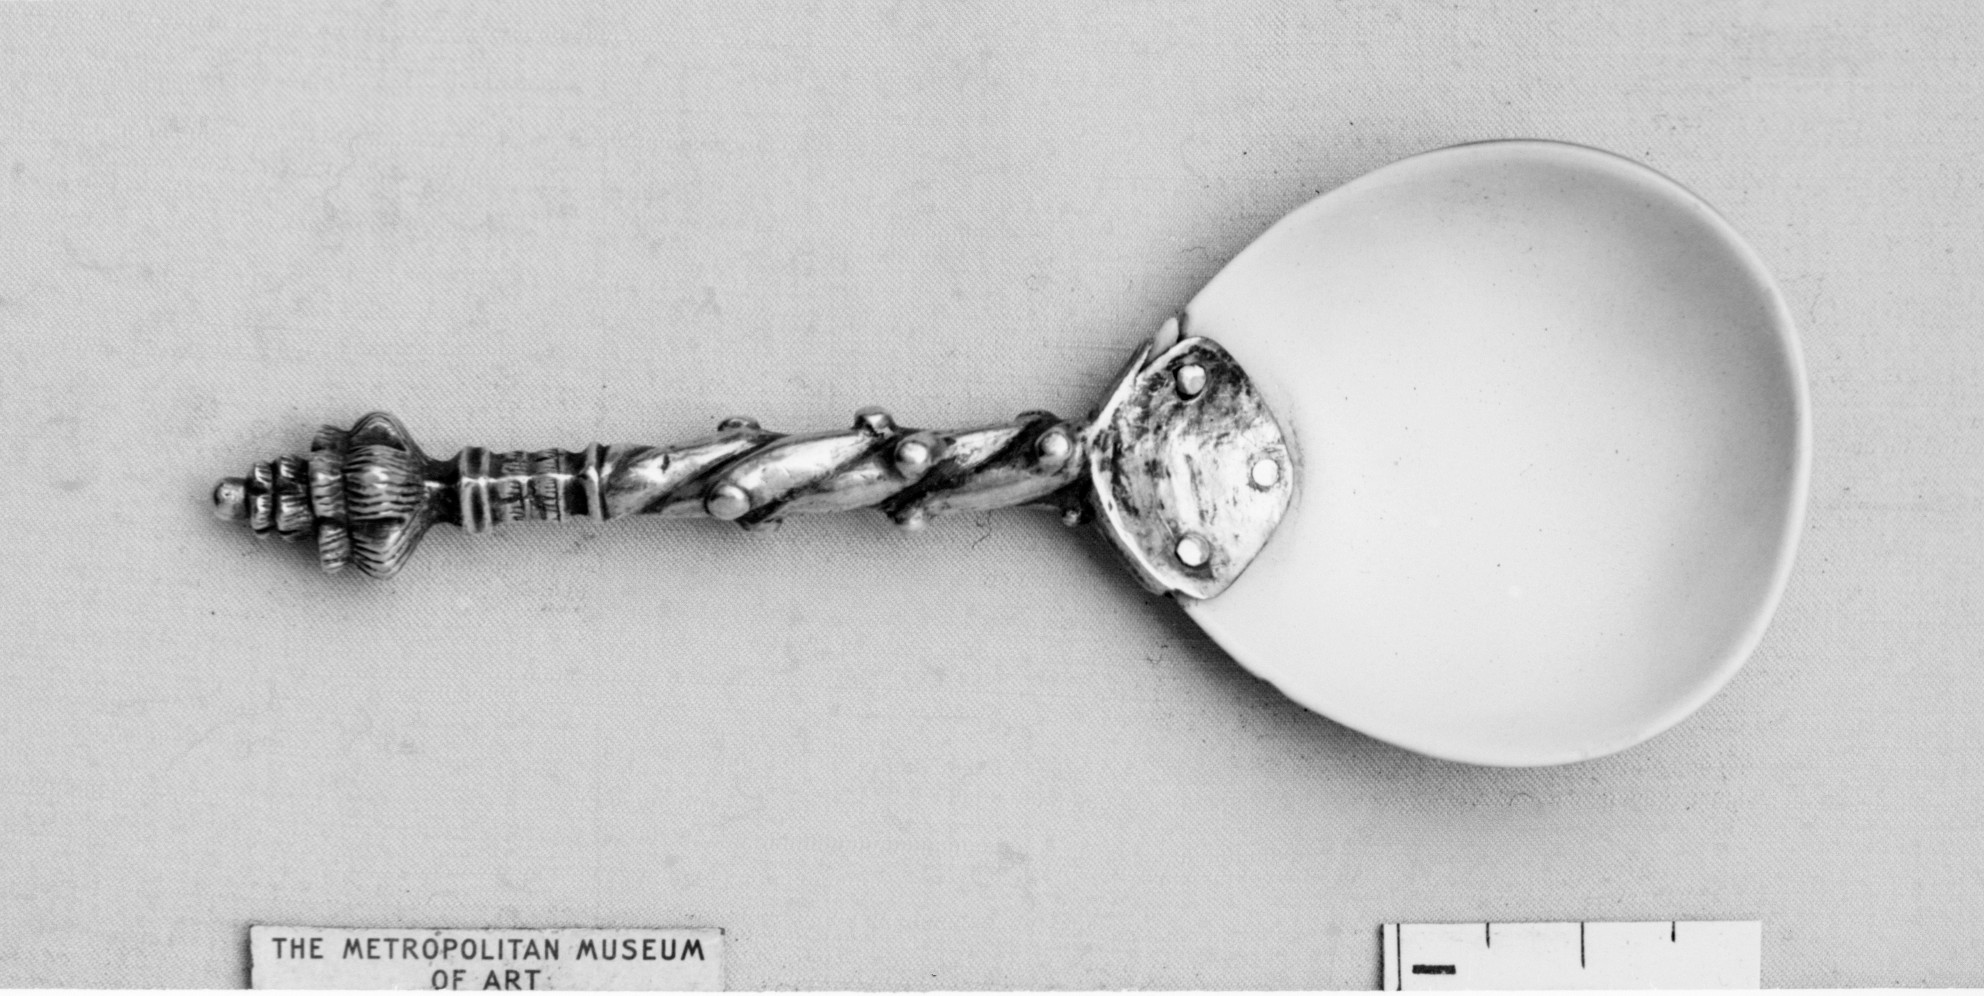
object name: spoon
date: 1701-1800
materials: shell, silver